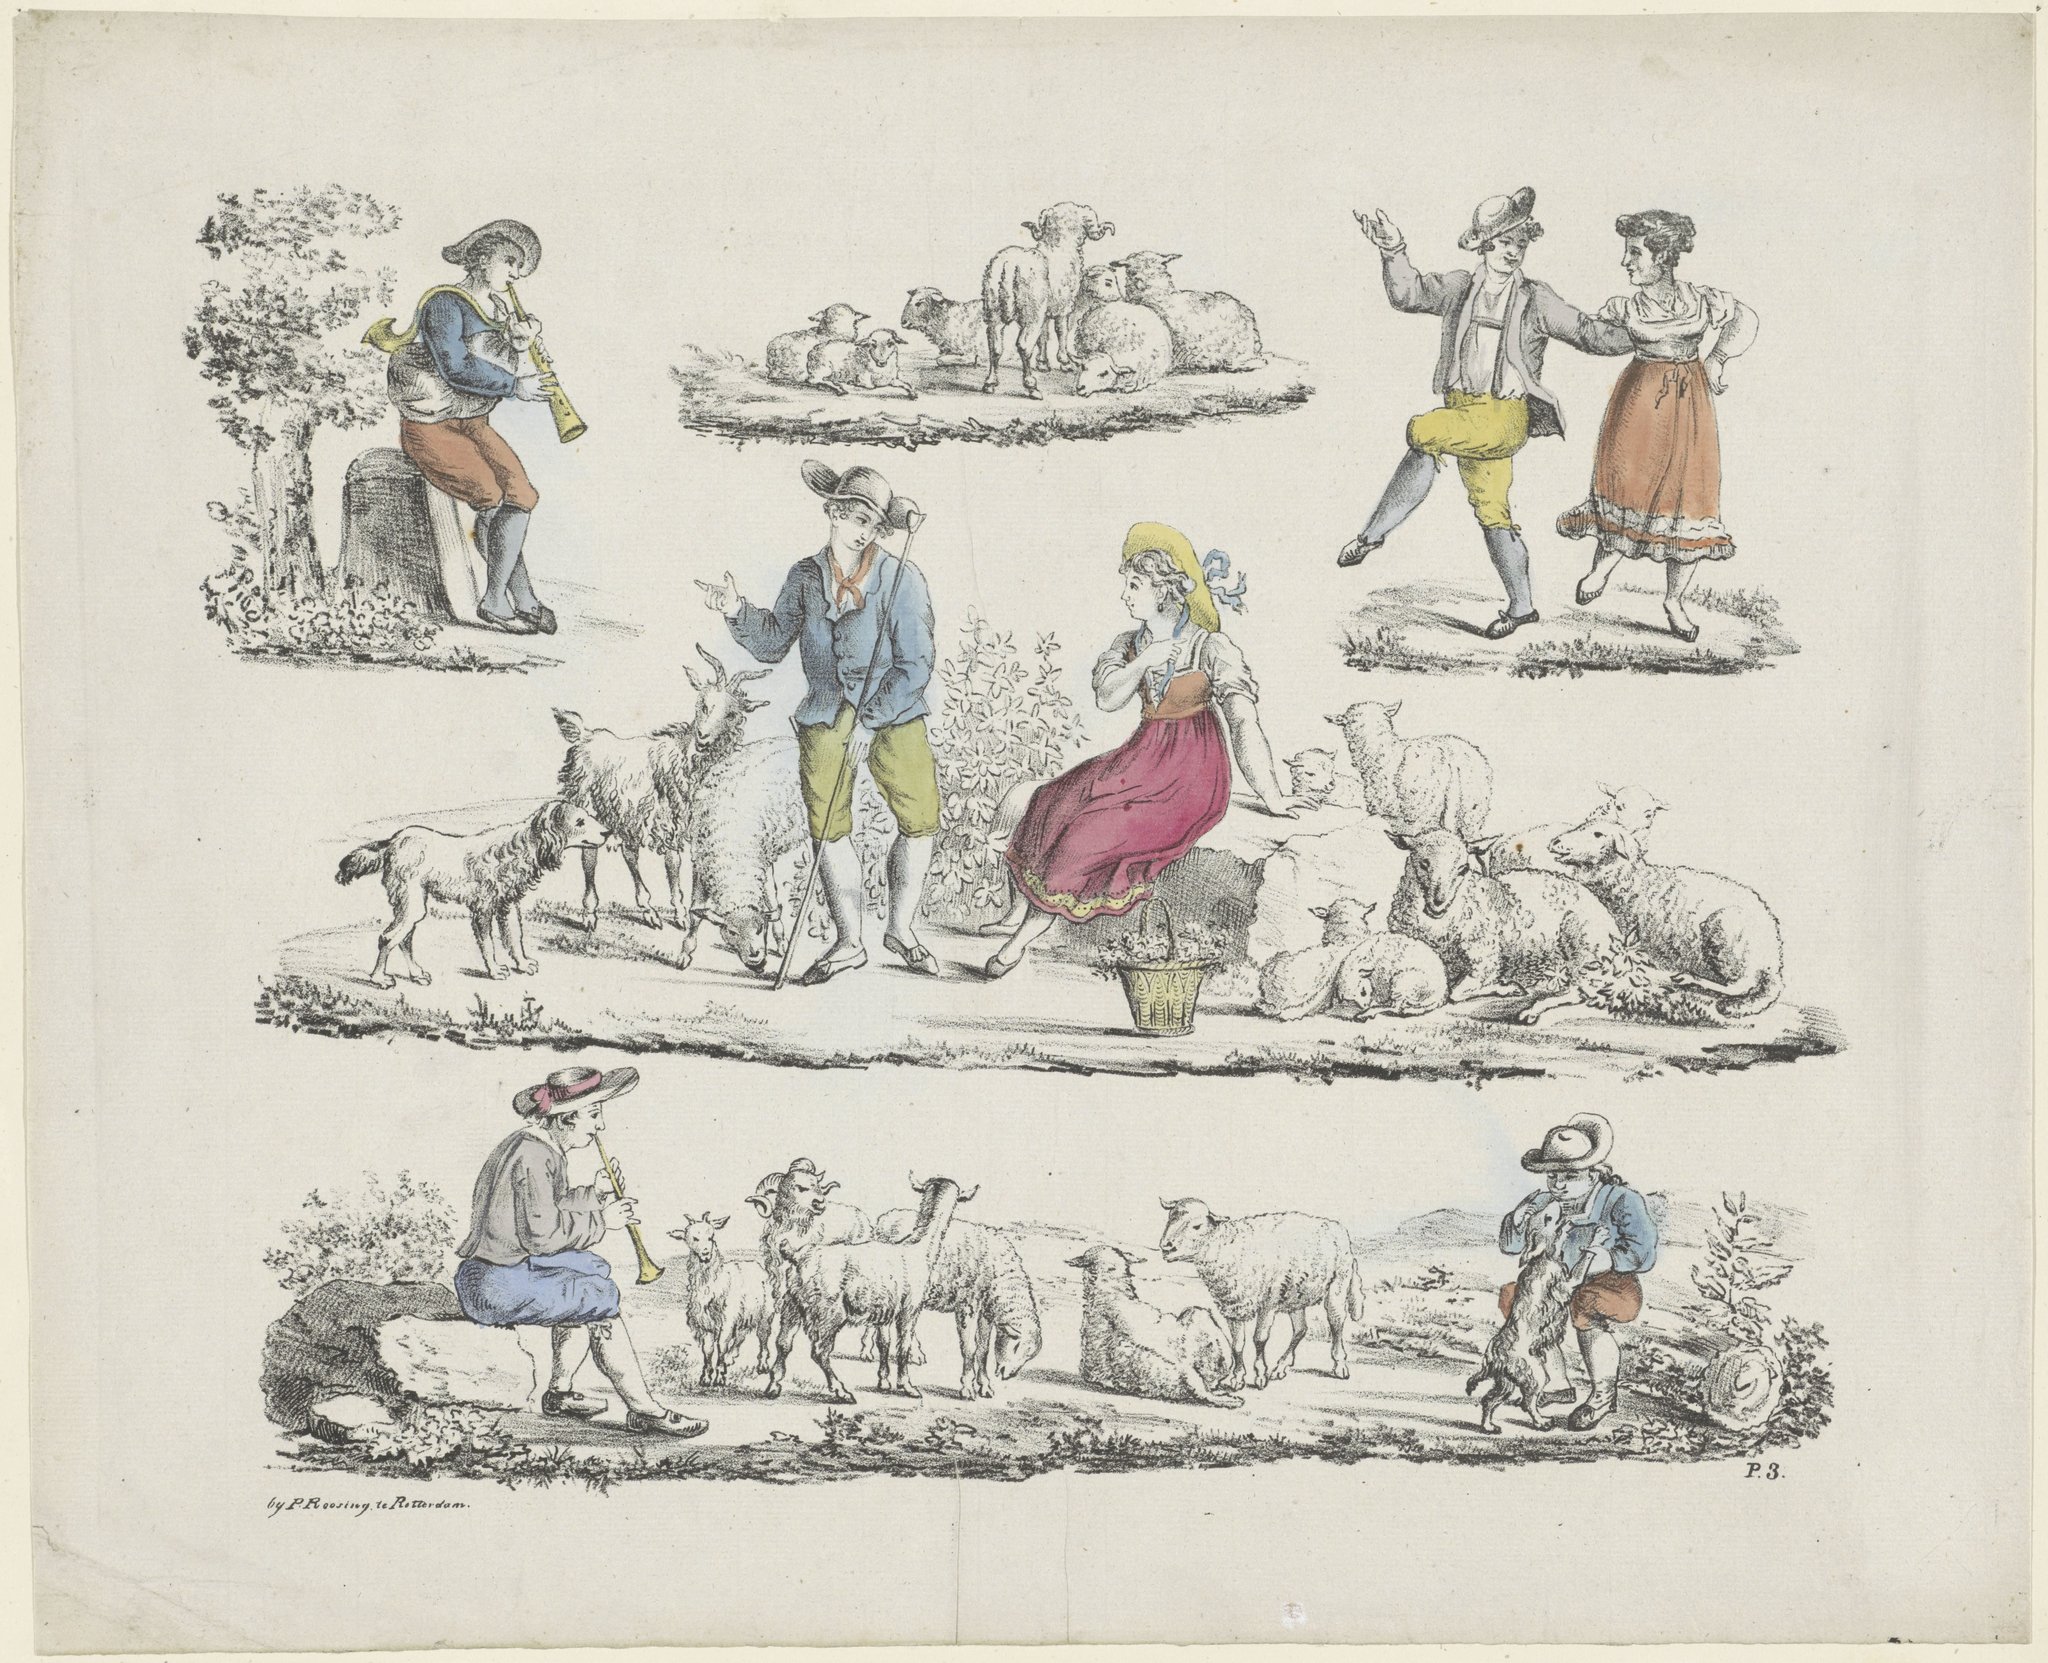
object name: popular print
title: Pastorale taferelen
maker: pieter roosing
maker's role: print maker, publisher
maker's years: 1794-1839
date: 1814-1839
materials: paper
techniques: hand coloring, lithograph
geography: rotterdam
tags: sheep, pastorals, arcadian scenes, herd, flock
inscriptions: collector's mark: Lugt 2760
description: Blad met 5 pastorale taferelen, waaronder een dansende herder en herderin, rustende schapen en herders die blaasinstrumenten bespelen. Genummerd rechtsonder: P. 3.